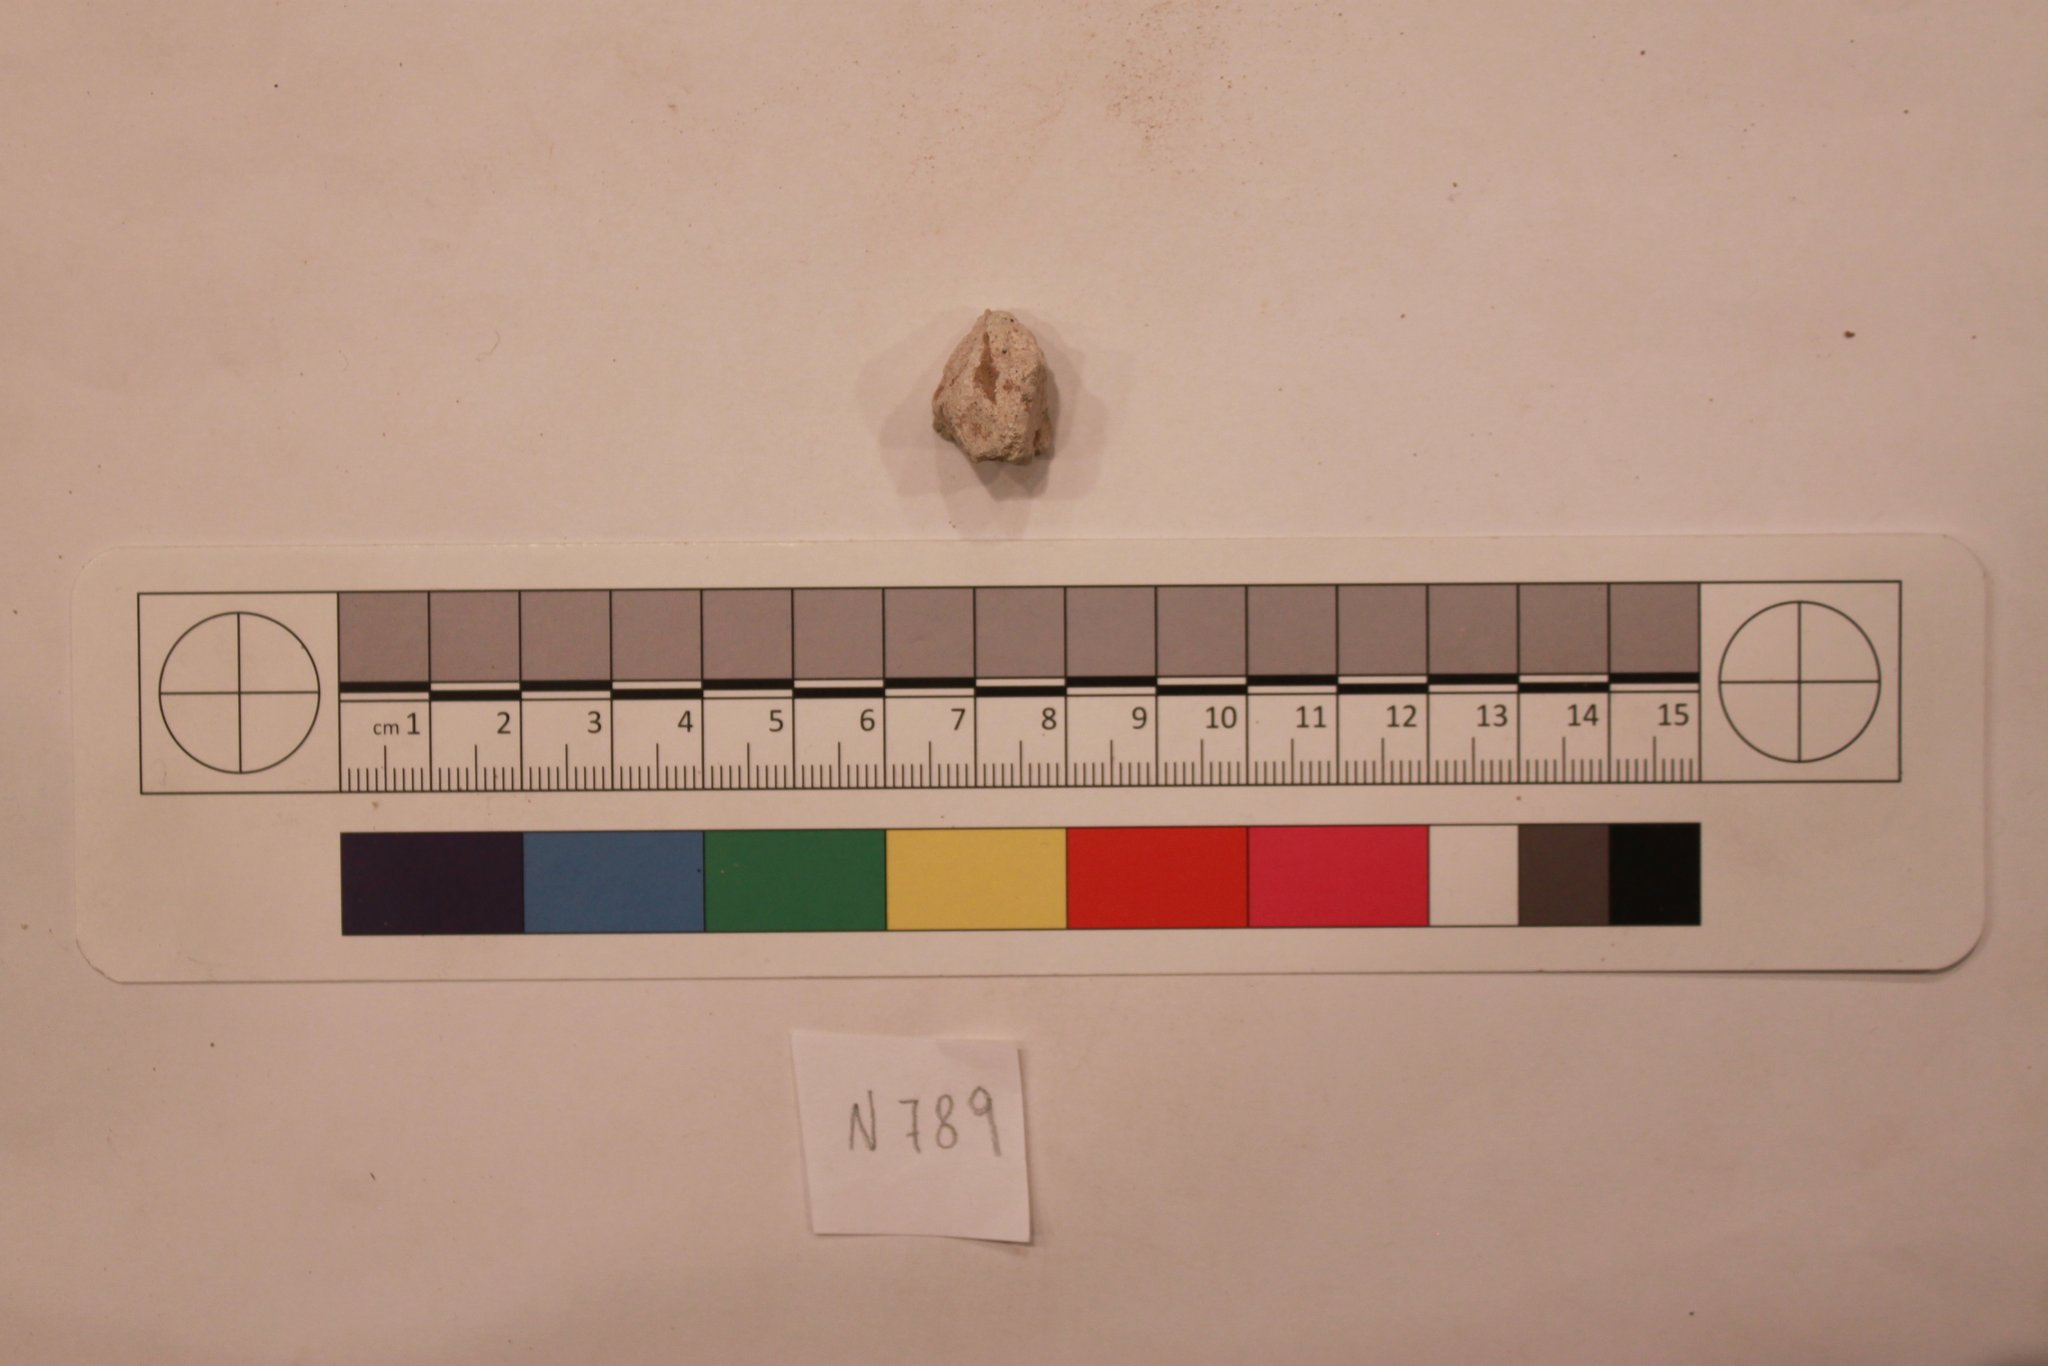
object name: fragment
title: Stucco Fragment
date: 701-1200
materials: plaster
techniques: carving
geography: iran